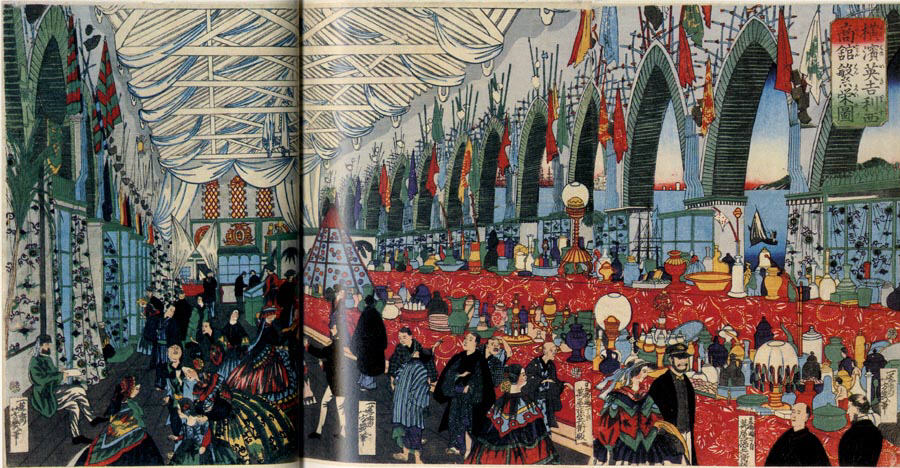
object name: print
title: Picture of a Prosperous English Trading Firm in Yokohama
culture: japanese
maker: utagawa yoshiiku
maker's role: artist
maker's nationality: japanese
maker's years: 1833-1904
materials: ink, paper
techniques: woodblock print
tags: crowd